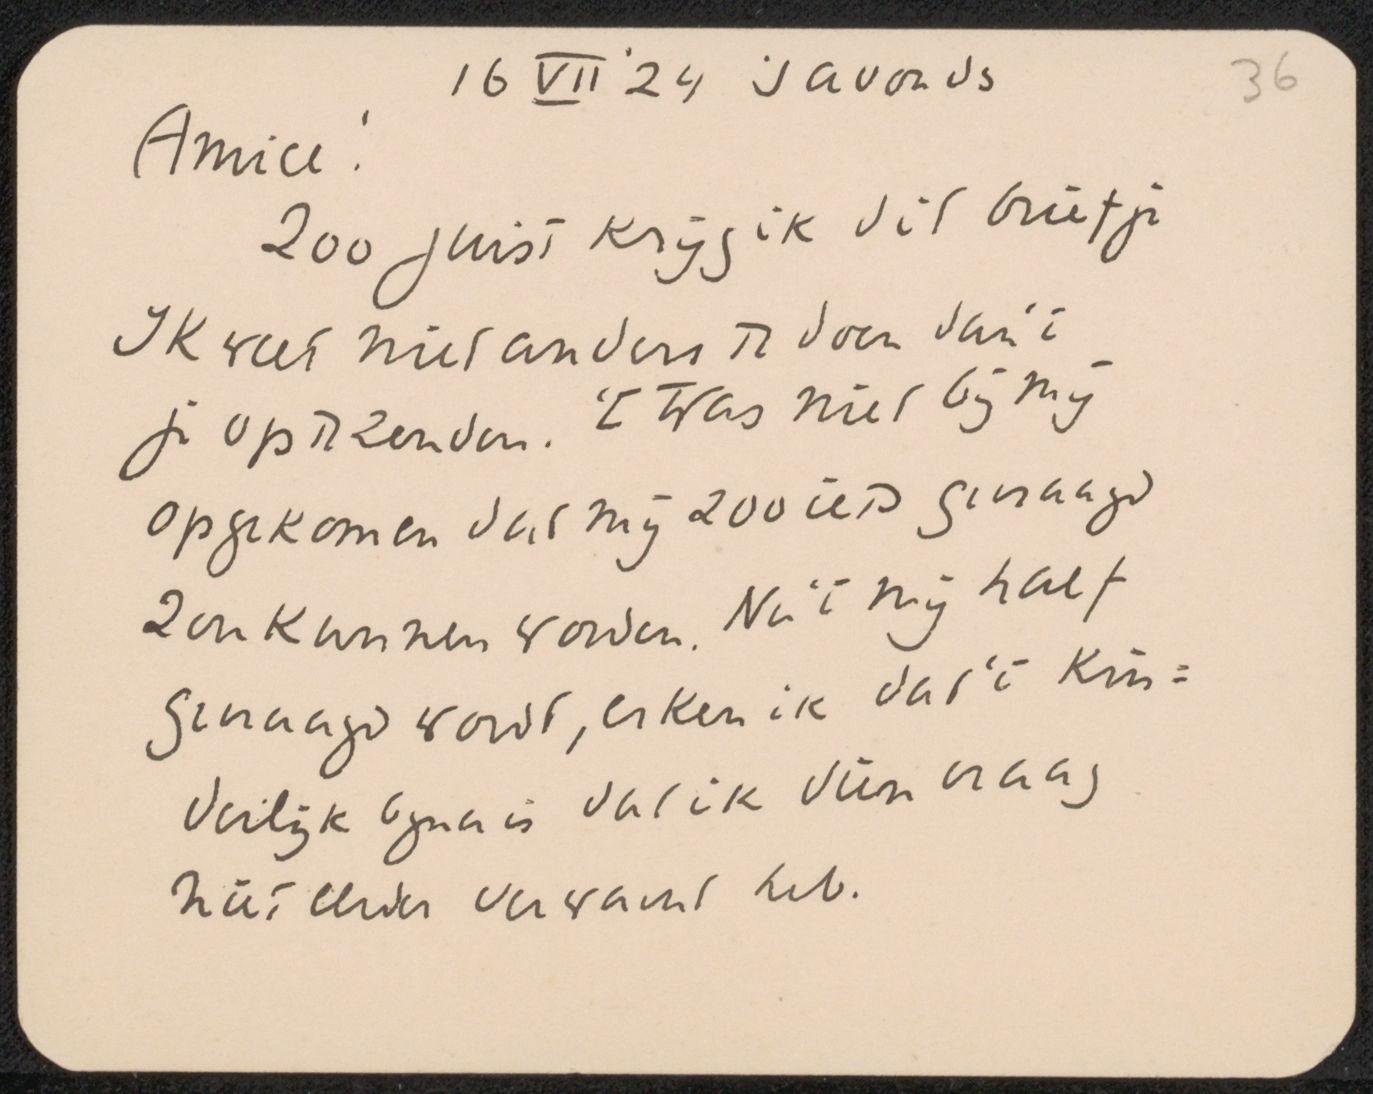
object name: letter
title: Brief aan Willem Bogtman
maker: richard nicolaüs roland holst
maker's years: 1868-1938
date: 1924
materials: cardboard, ink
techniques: pen, writing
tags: haarlem, willem bogtman, applied arts, arts and crafts; industrial design, paris